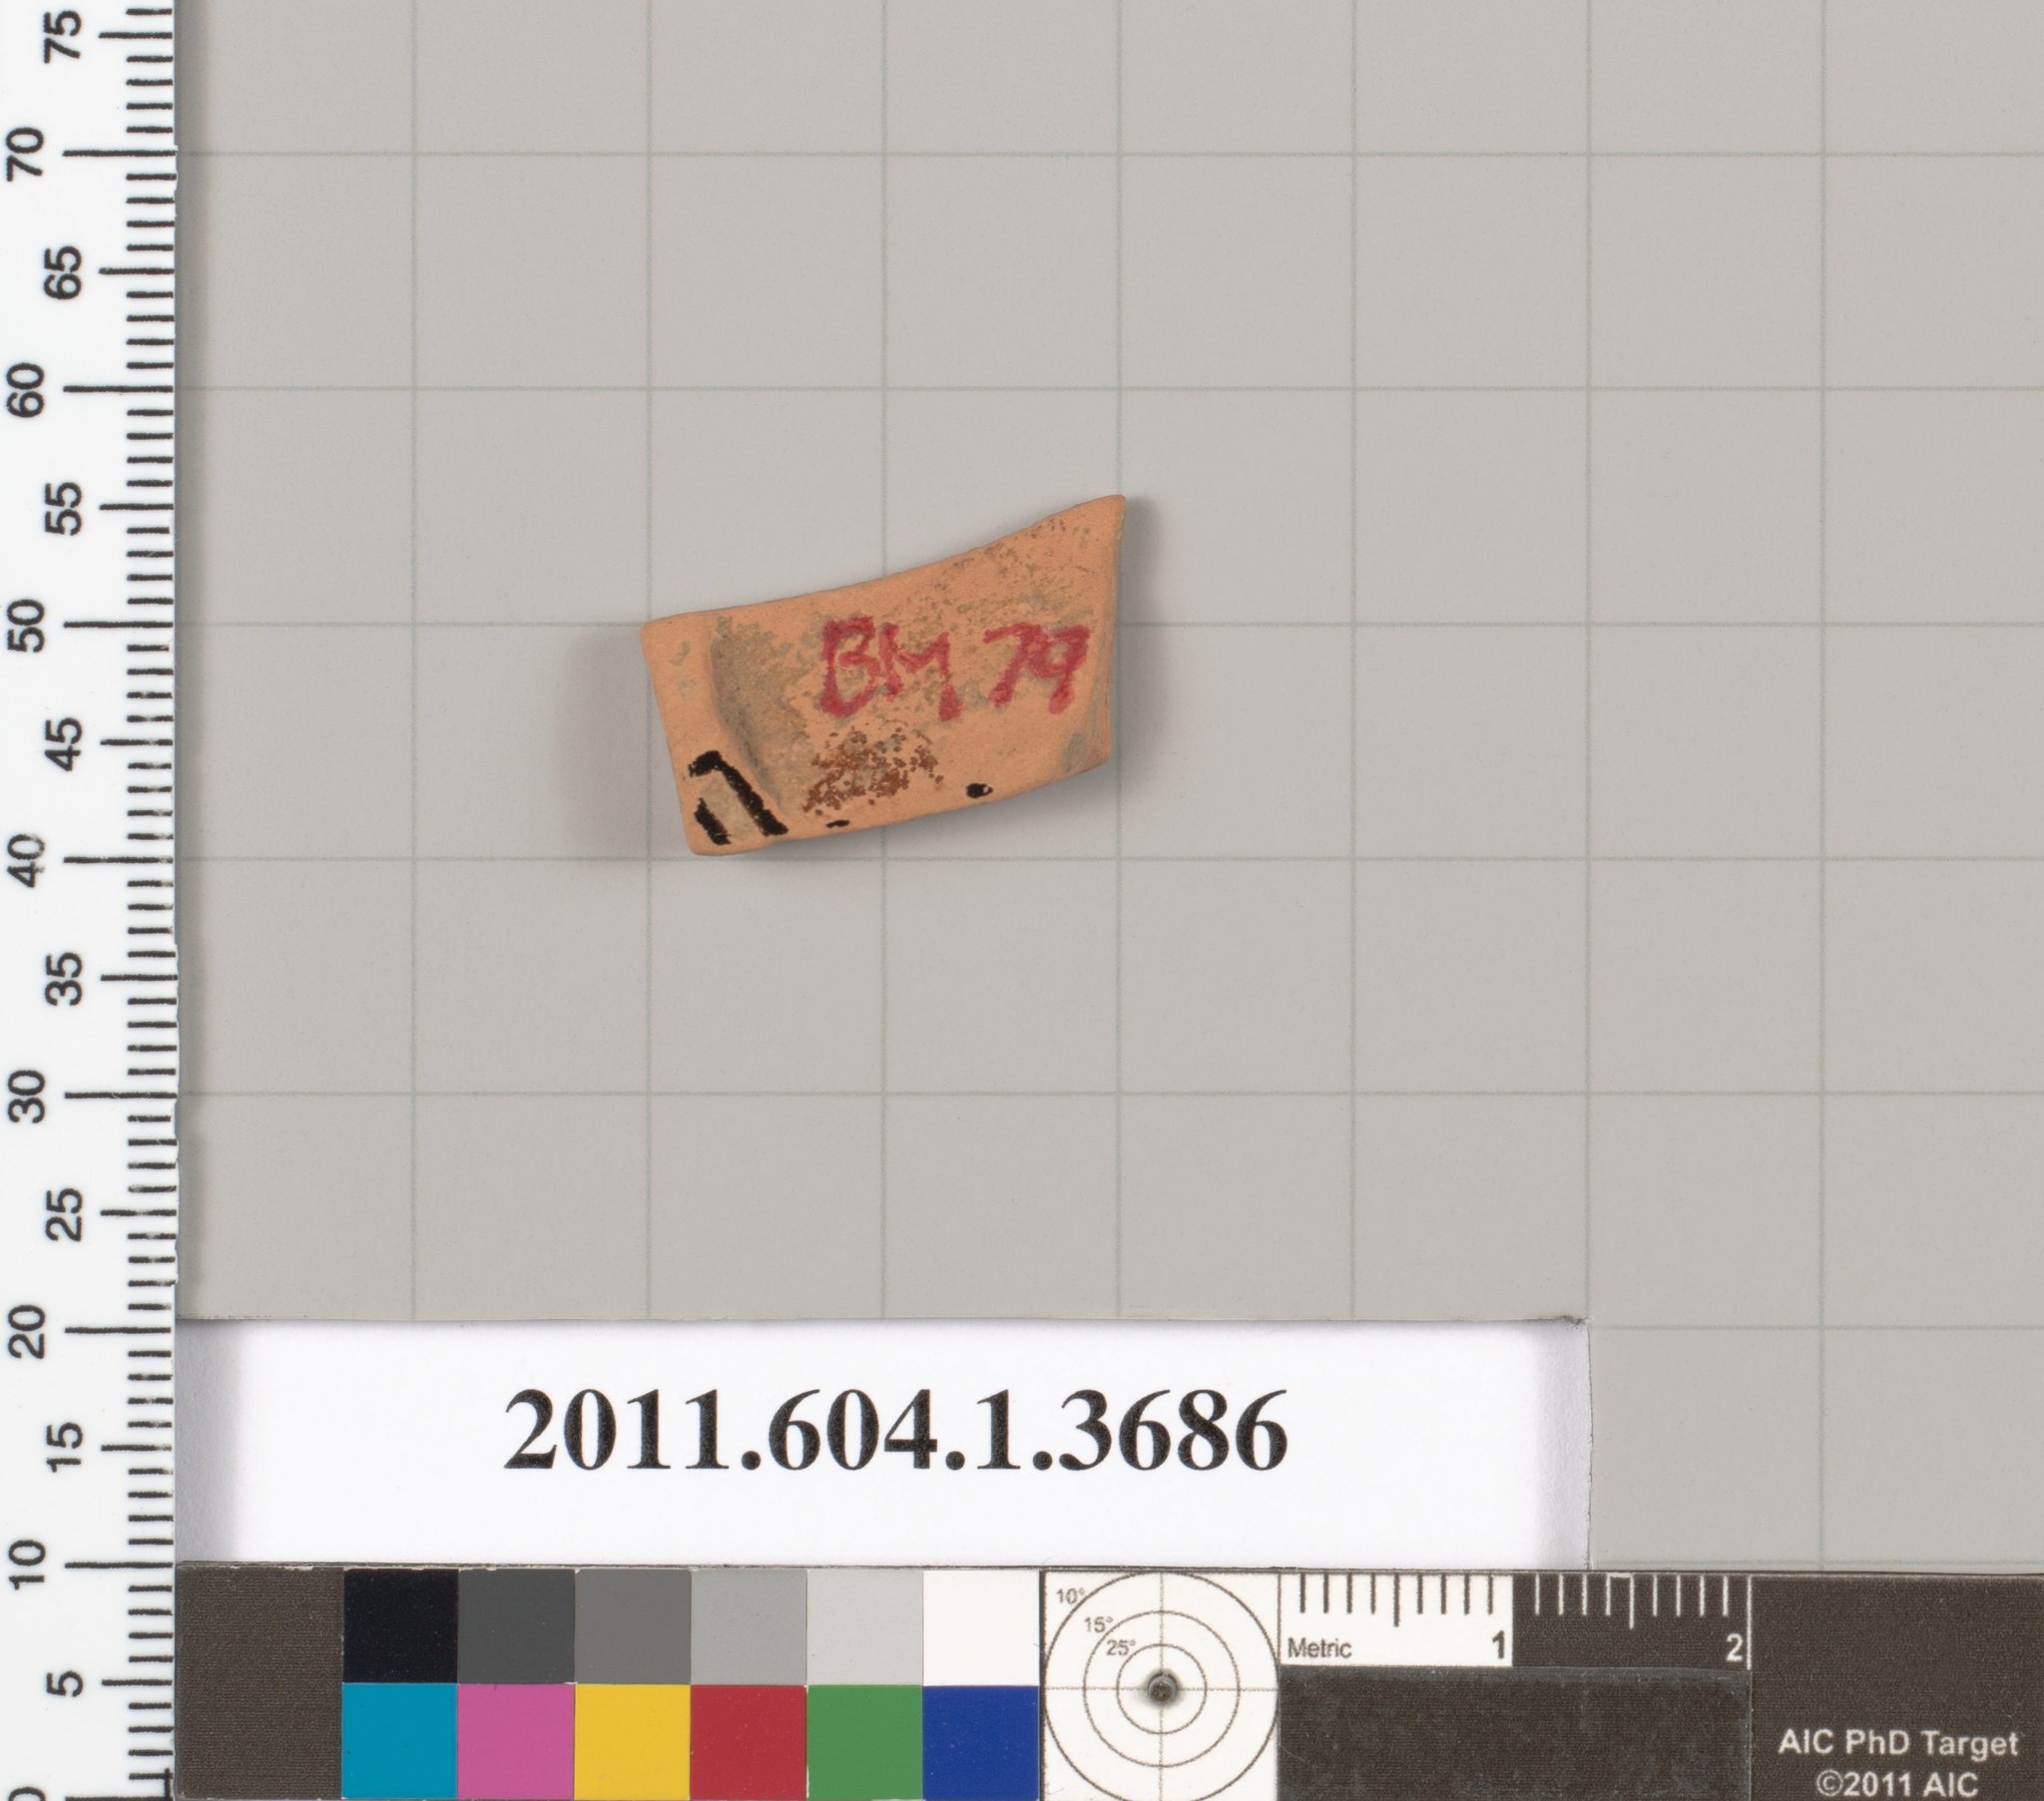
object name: kylix fragment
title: Terracotta fragment of a kylix (drinking cup)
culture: greek, attic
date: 475-451 BCE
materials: terracotta